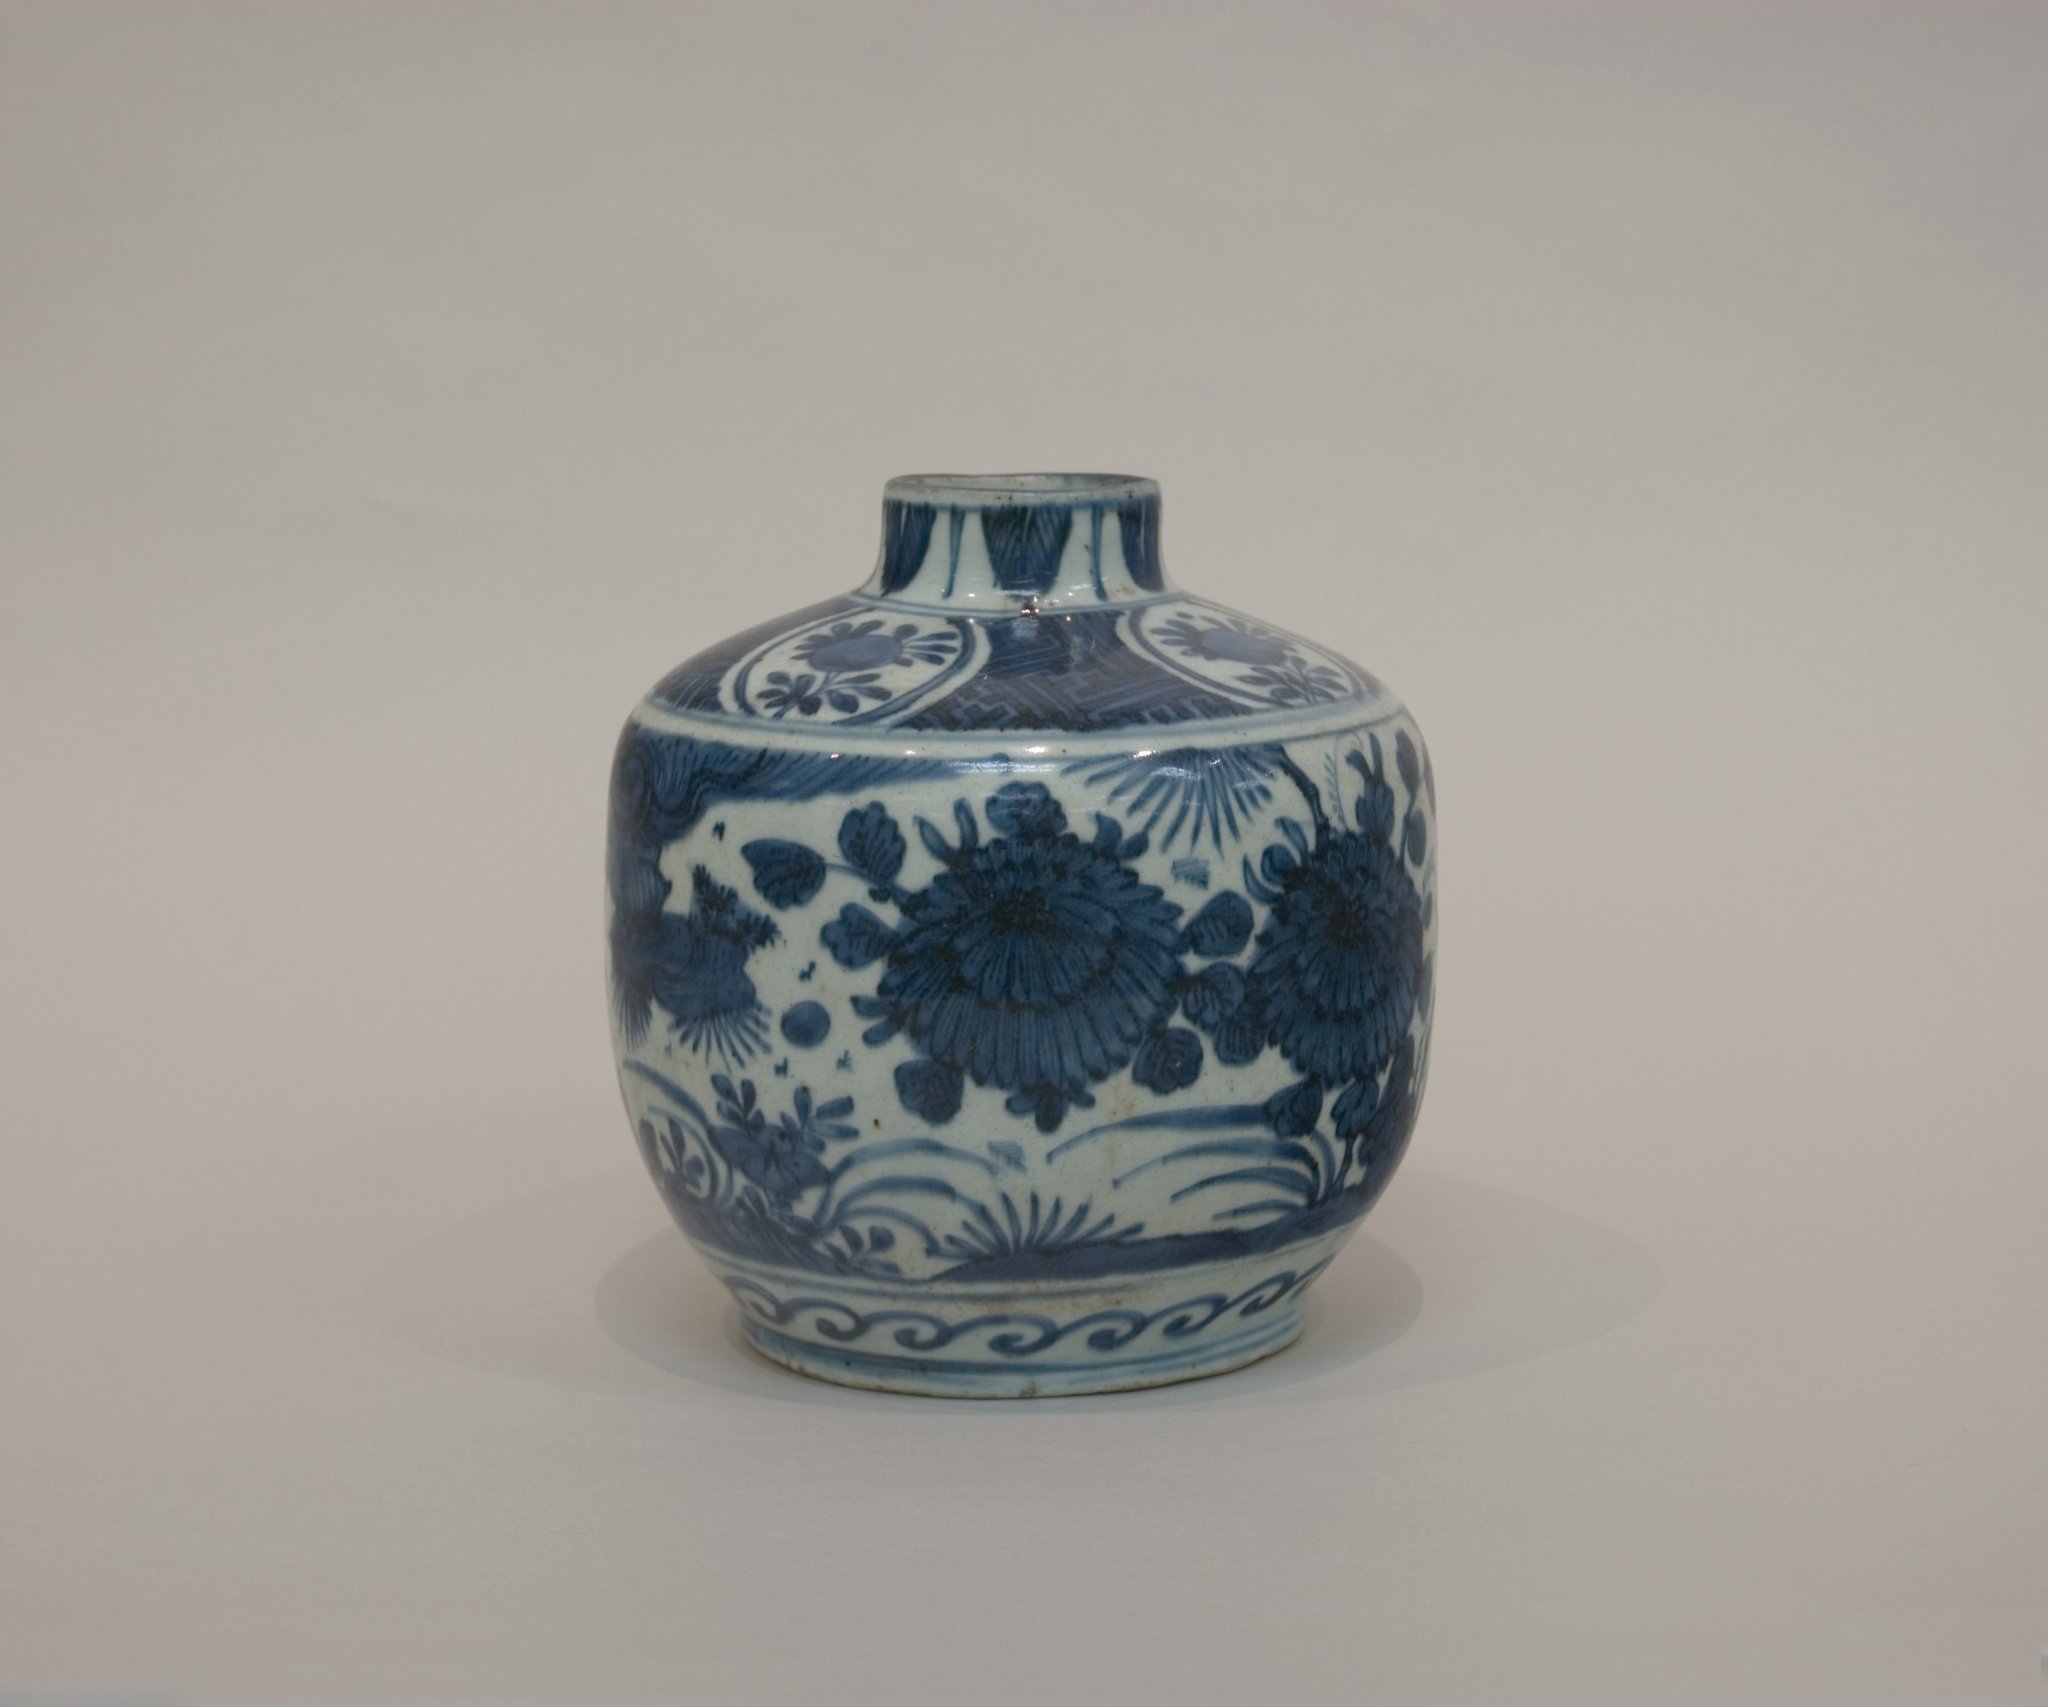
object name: bottle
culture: chinese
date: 1567-1633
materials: cobalt, porcelain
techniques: painting, underglaze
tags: flowers